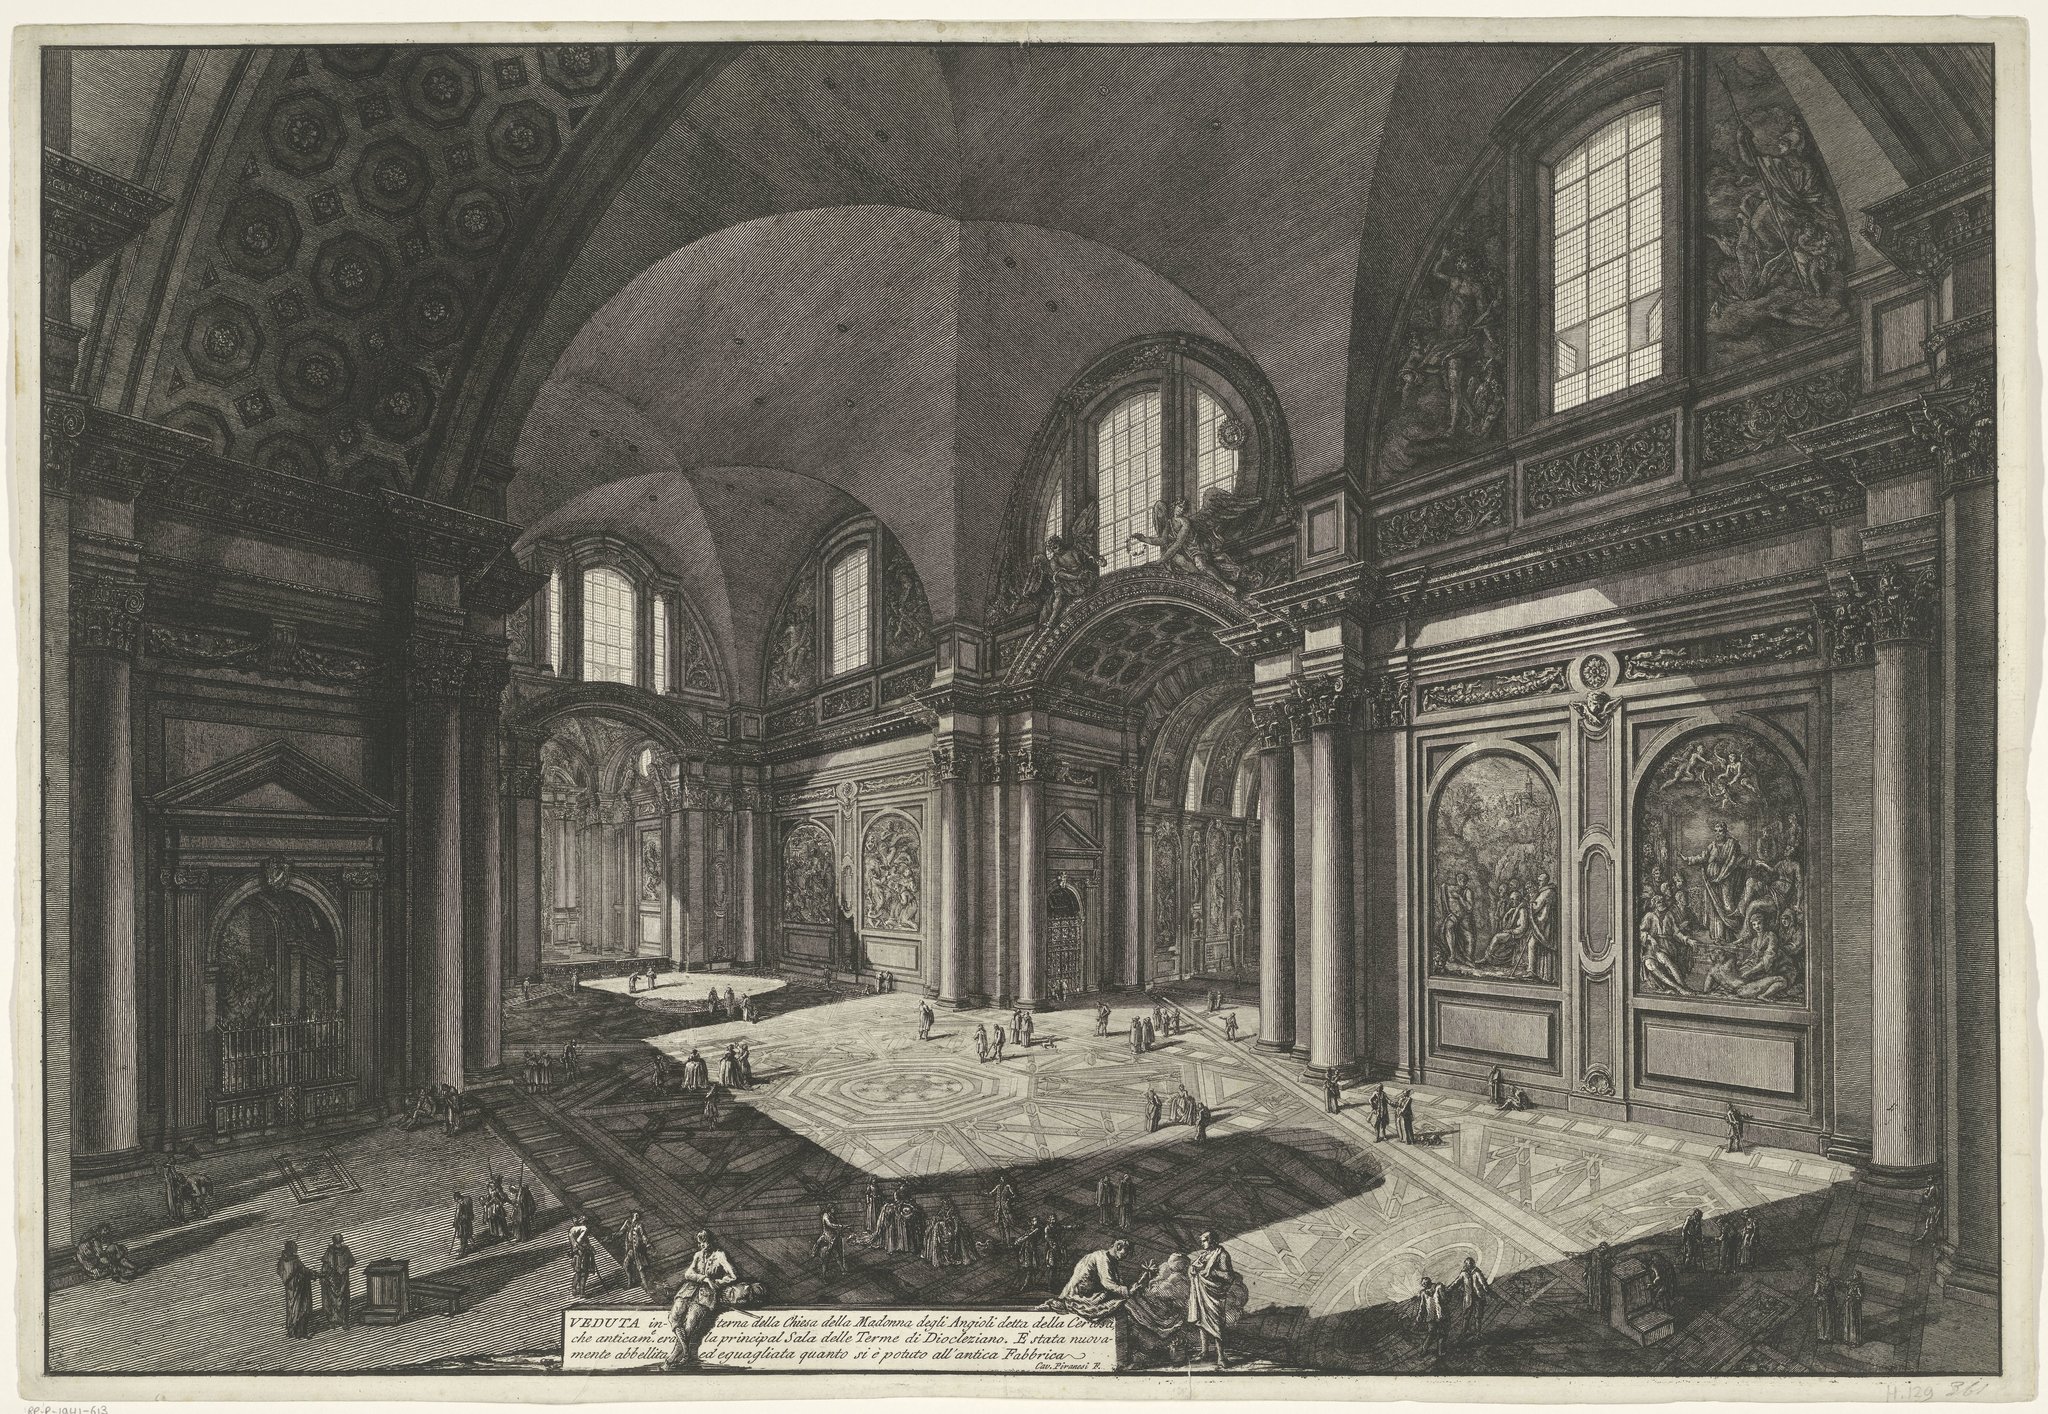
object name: print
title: Veduta interna della Chiesa della Madonna degli Anioli della della Certosa che anticam.e era la principal Sala delle Terme di Diocleziano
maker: giovanni battista piranesi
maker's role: designer, draughtsman, print maker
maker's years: 1720-1778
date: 1748-1778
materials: paper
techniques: etching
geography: rome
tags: roman catholic church, interior of church, rome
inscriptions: collector's mark: Lugt 2228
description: Deze prent maakt deel uit van de serie 'Vedute di Roma'. Piranesi werkte aan deze 135 platen tellende serie tussen 1748 en zijn dood in 1778. Francesco Piranesi voegde later nog twee prenten toe aan de reeks van zijn vader.